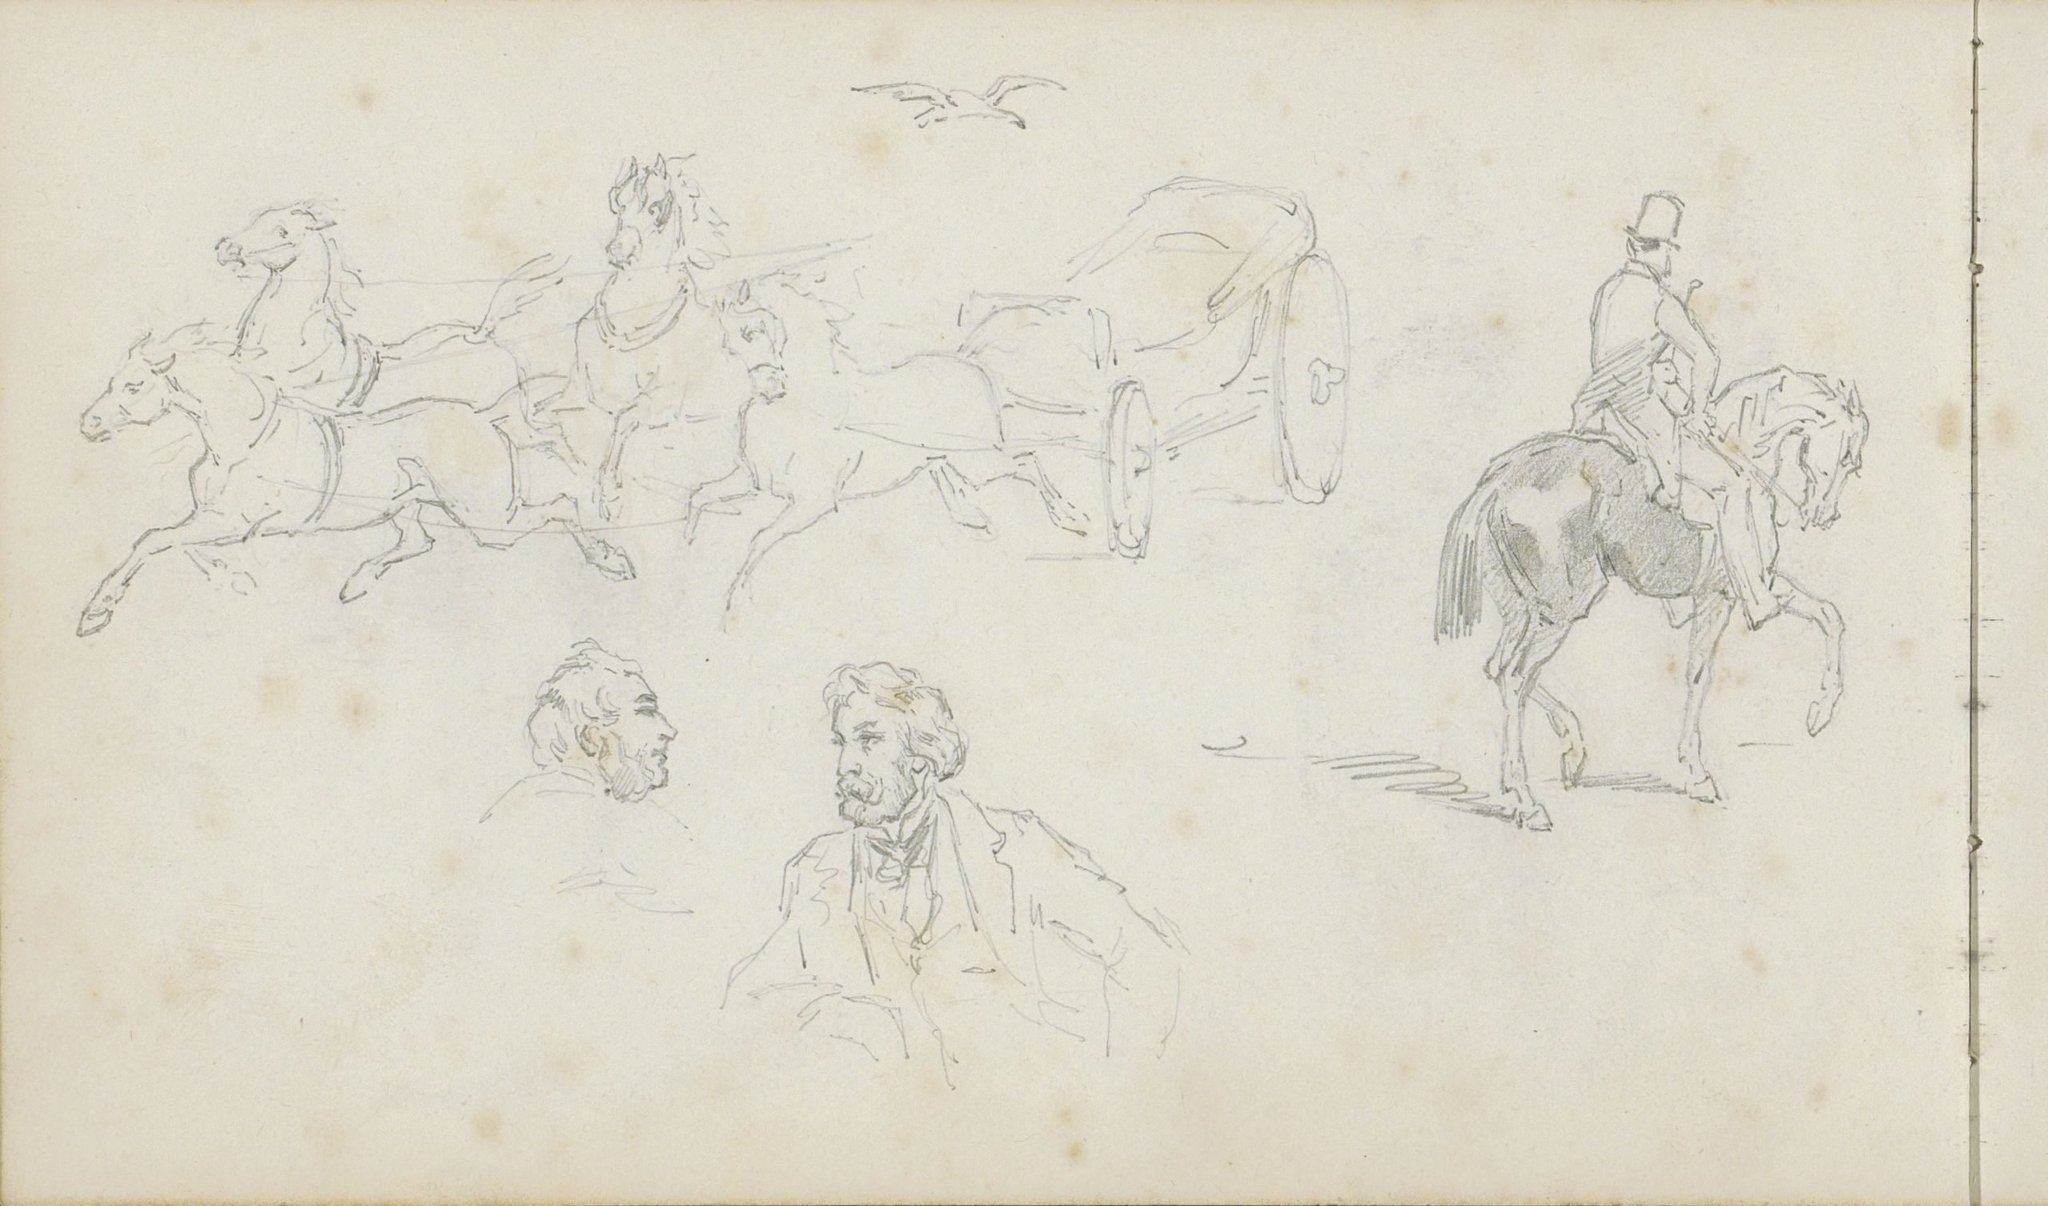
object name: sketchbook leaf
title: Lege koets getrokken door vier paarden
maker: charles rochussen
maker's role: draughtsman, painter, print maker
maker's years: 1814-1894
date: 1840-1860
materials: paper, pencil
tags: riding a horse, ass, or mule; rider, horseman, four-wheeled, animal-drawn vehicle, e.g.: cab, carriage, coach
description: Tevens studies van een ruiter en mannen. Blad 23 verso uit een schetsboek met 38 bladen.